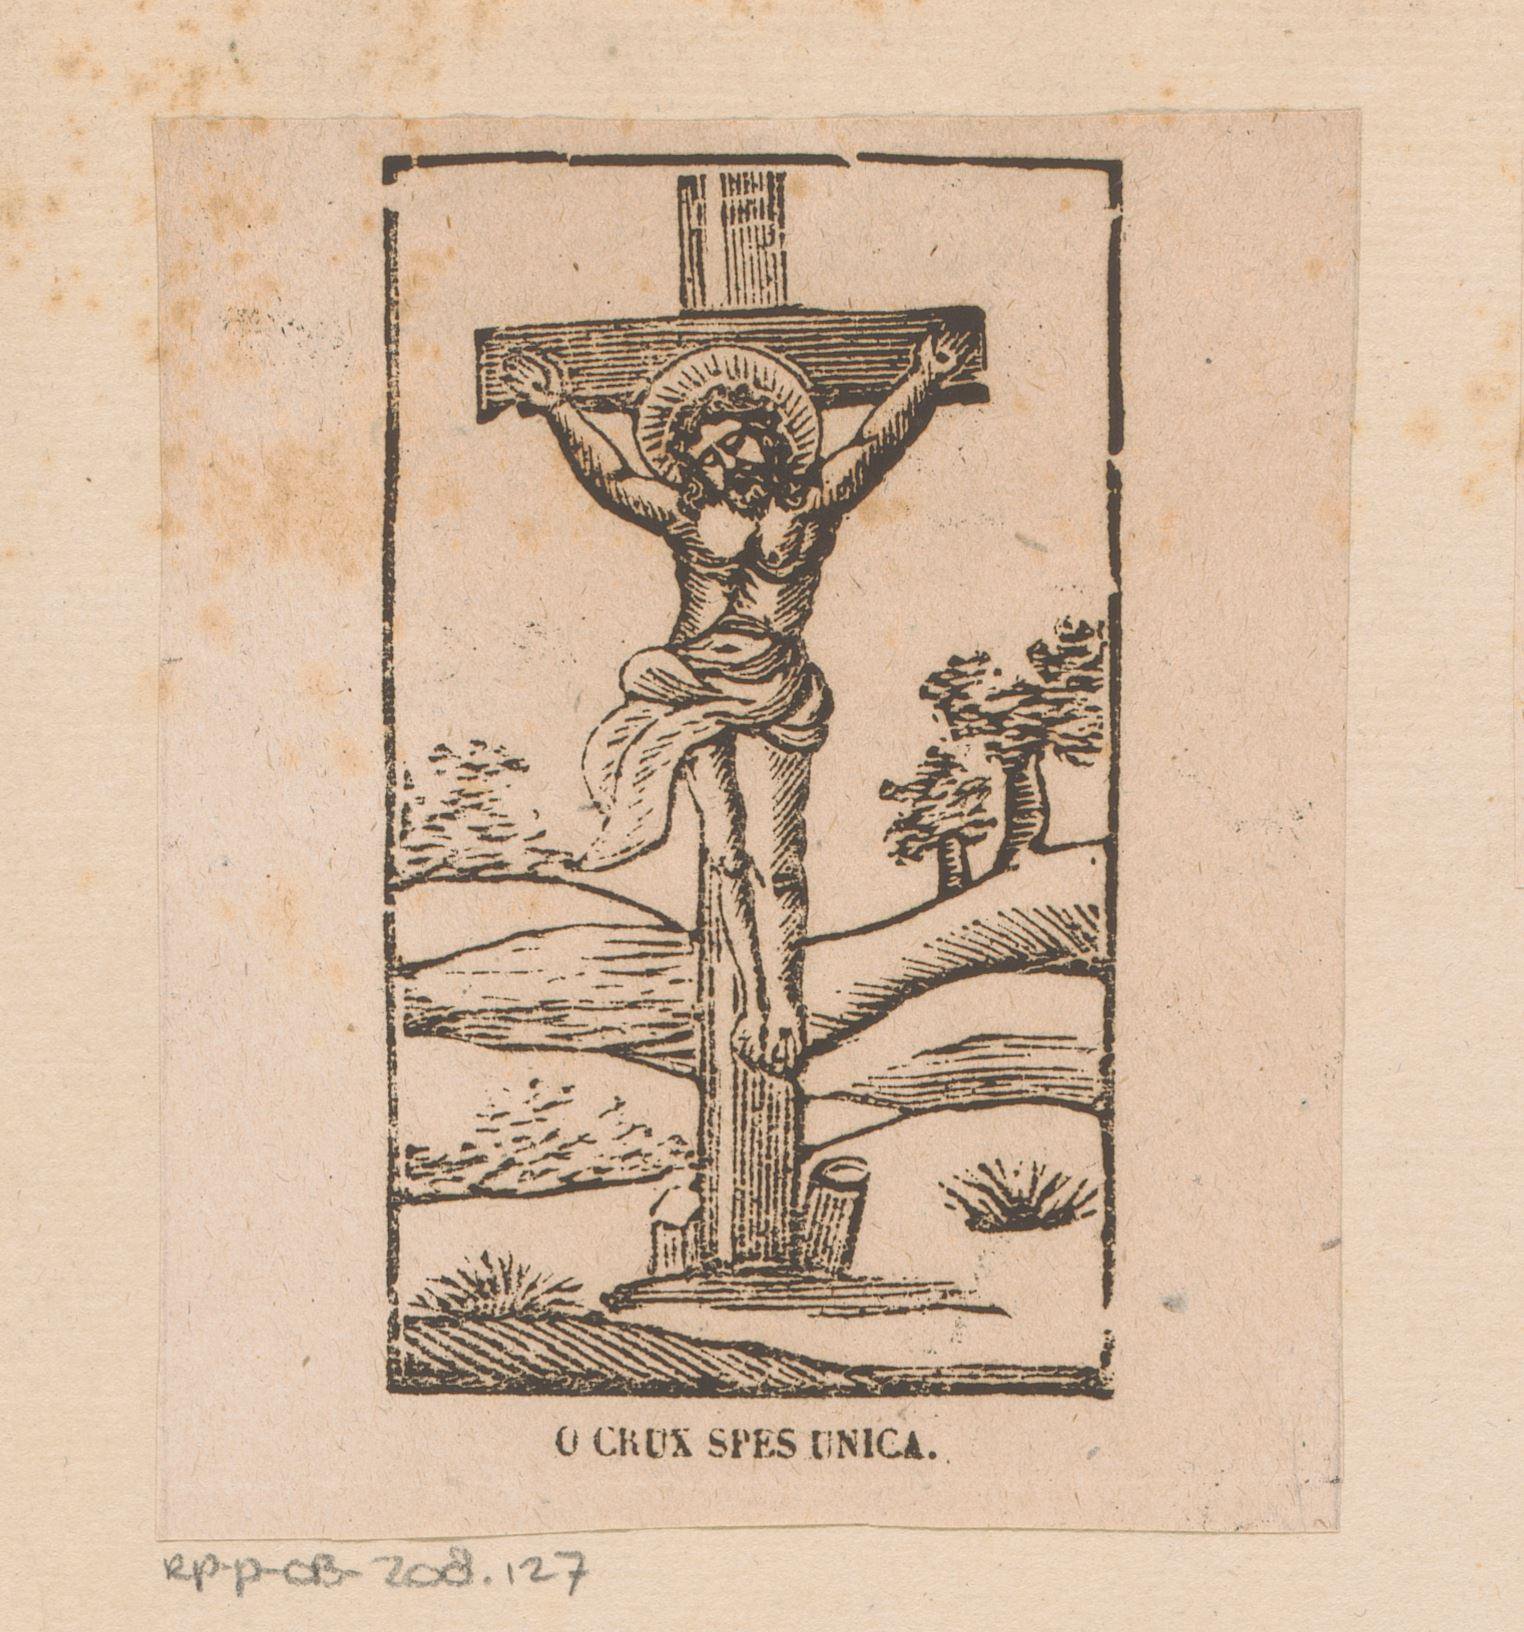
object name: print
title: Christus aan het kruis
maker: Anonymous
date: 1600-1699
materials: paper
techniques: letterpress printing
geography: netherlands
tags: christ on the cross on golgotha (alone, without bystanders)